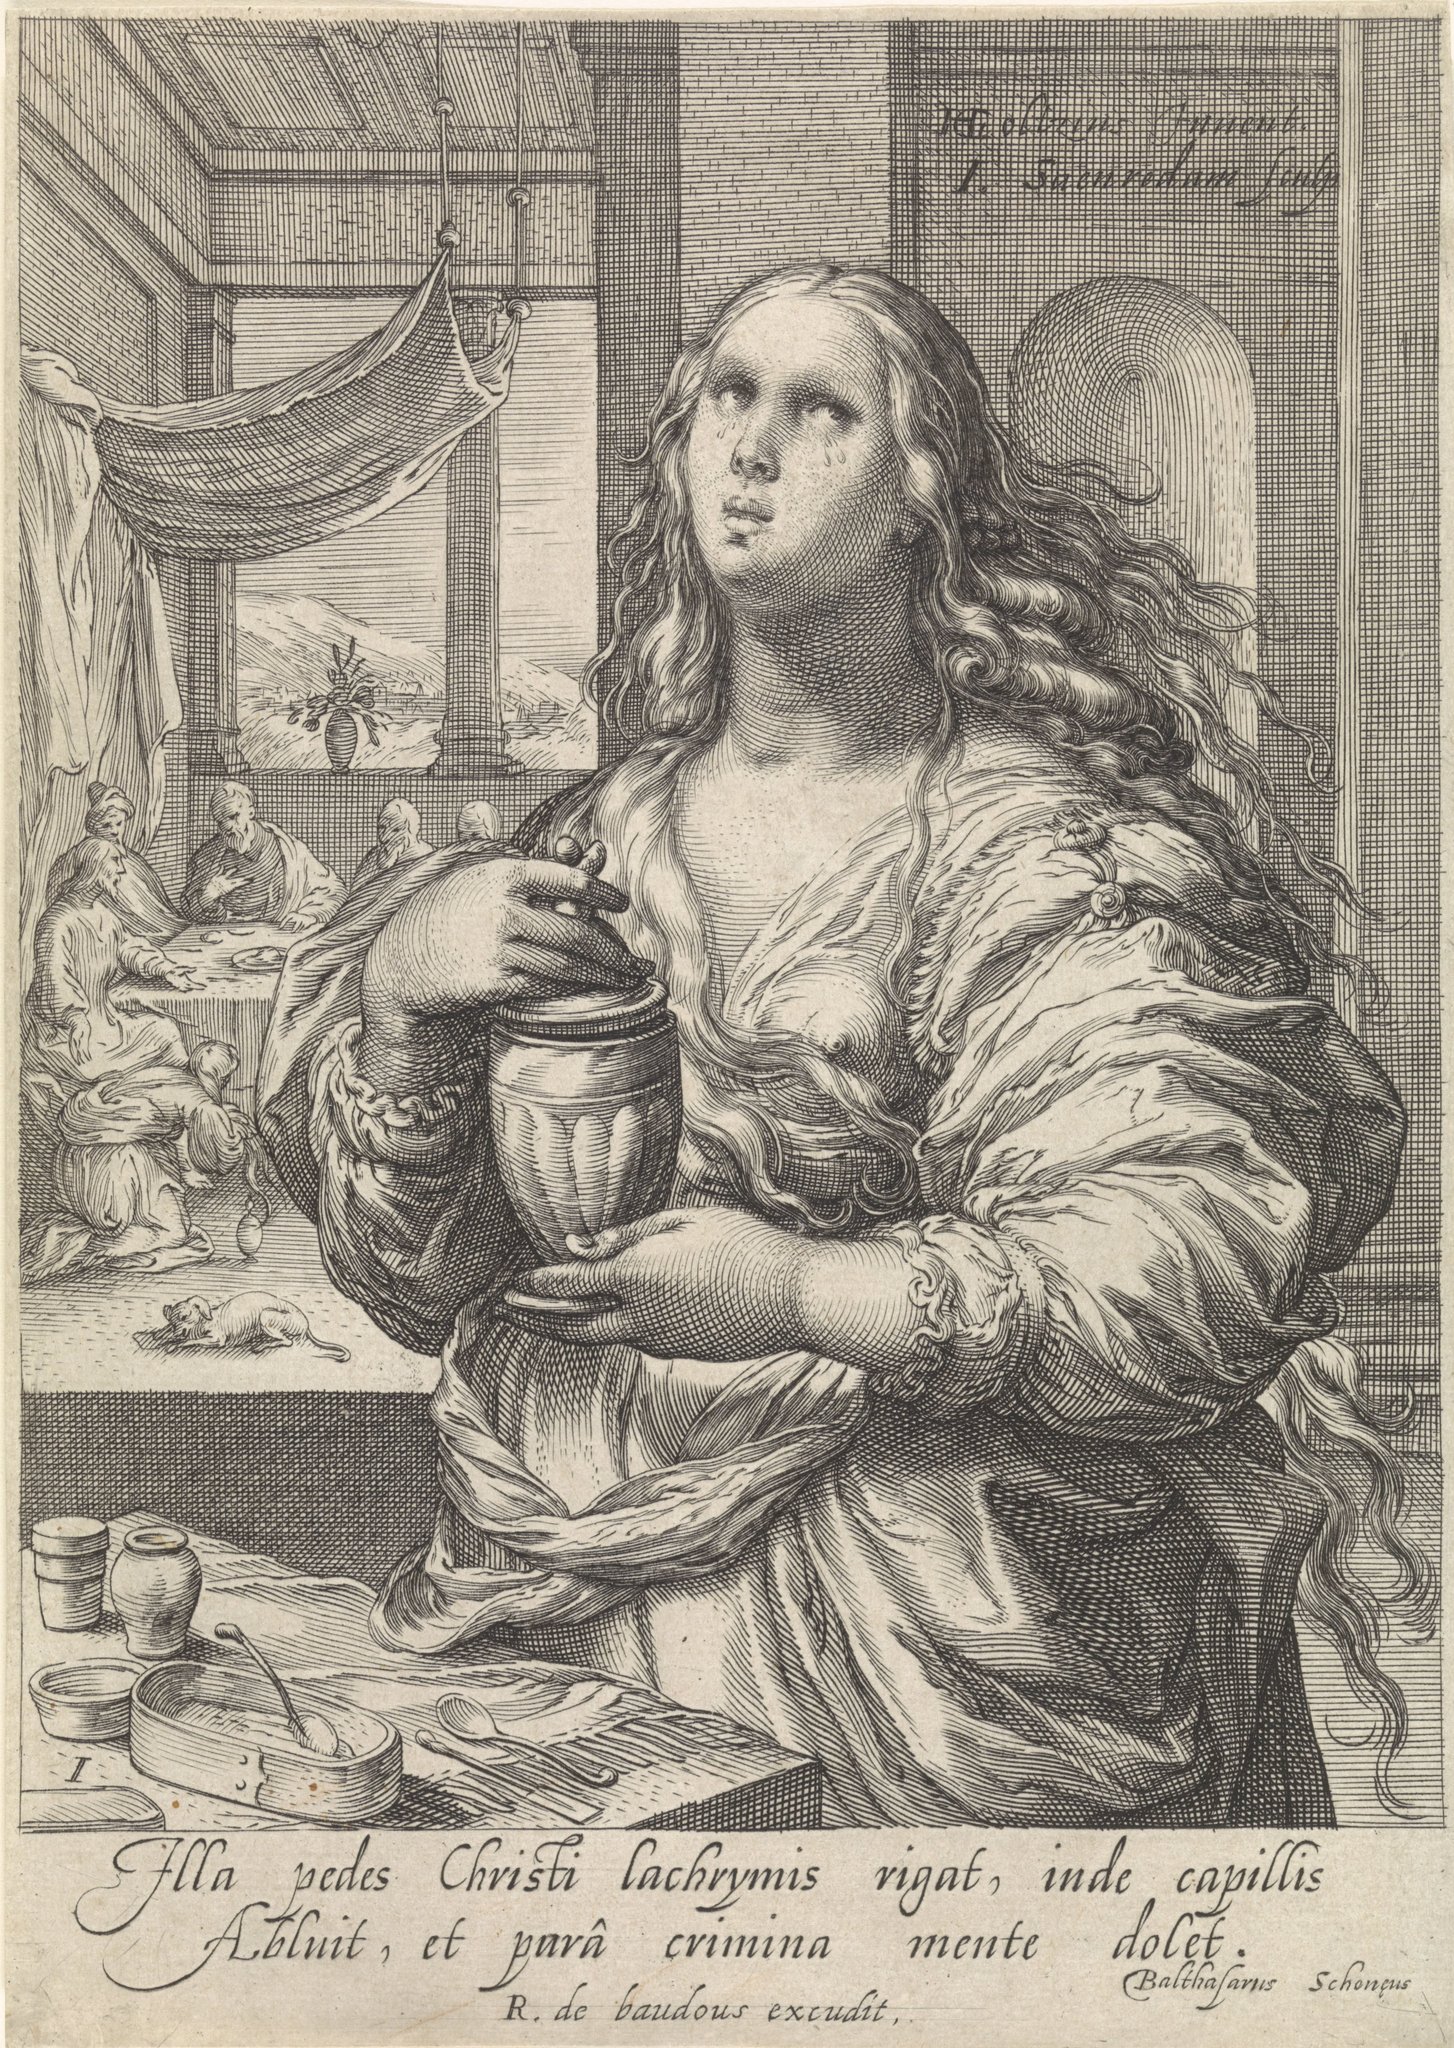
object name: print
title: Maria Magdalena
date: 1584-1659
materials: paper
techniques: engraving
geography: northern netherlands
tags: christ's feet are anointed by mary (magdalene), the penitent harlot mary magdalene; possible attributes: book (or scroll), crown, crown of thorns, crucifix, jar of ointment, mirror, musical instrument, palm-branch, rosary, scourge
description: Maria Magdalena, huilend, met in haar hand een kruik met balsemolie. Op de achtergrond zalft zij de voeten van Christus wanneer hij te gast is bij Simon de Farizeeër. De prent heeft een Latijns onderschrift en maakt deel uit van een prentserie met beroemde vrouwen uit het Nieuwe Testament